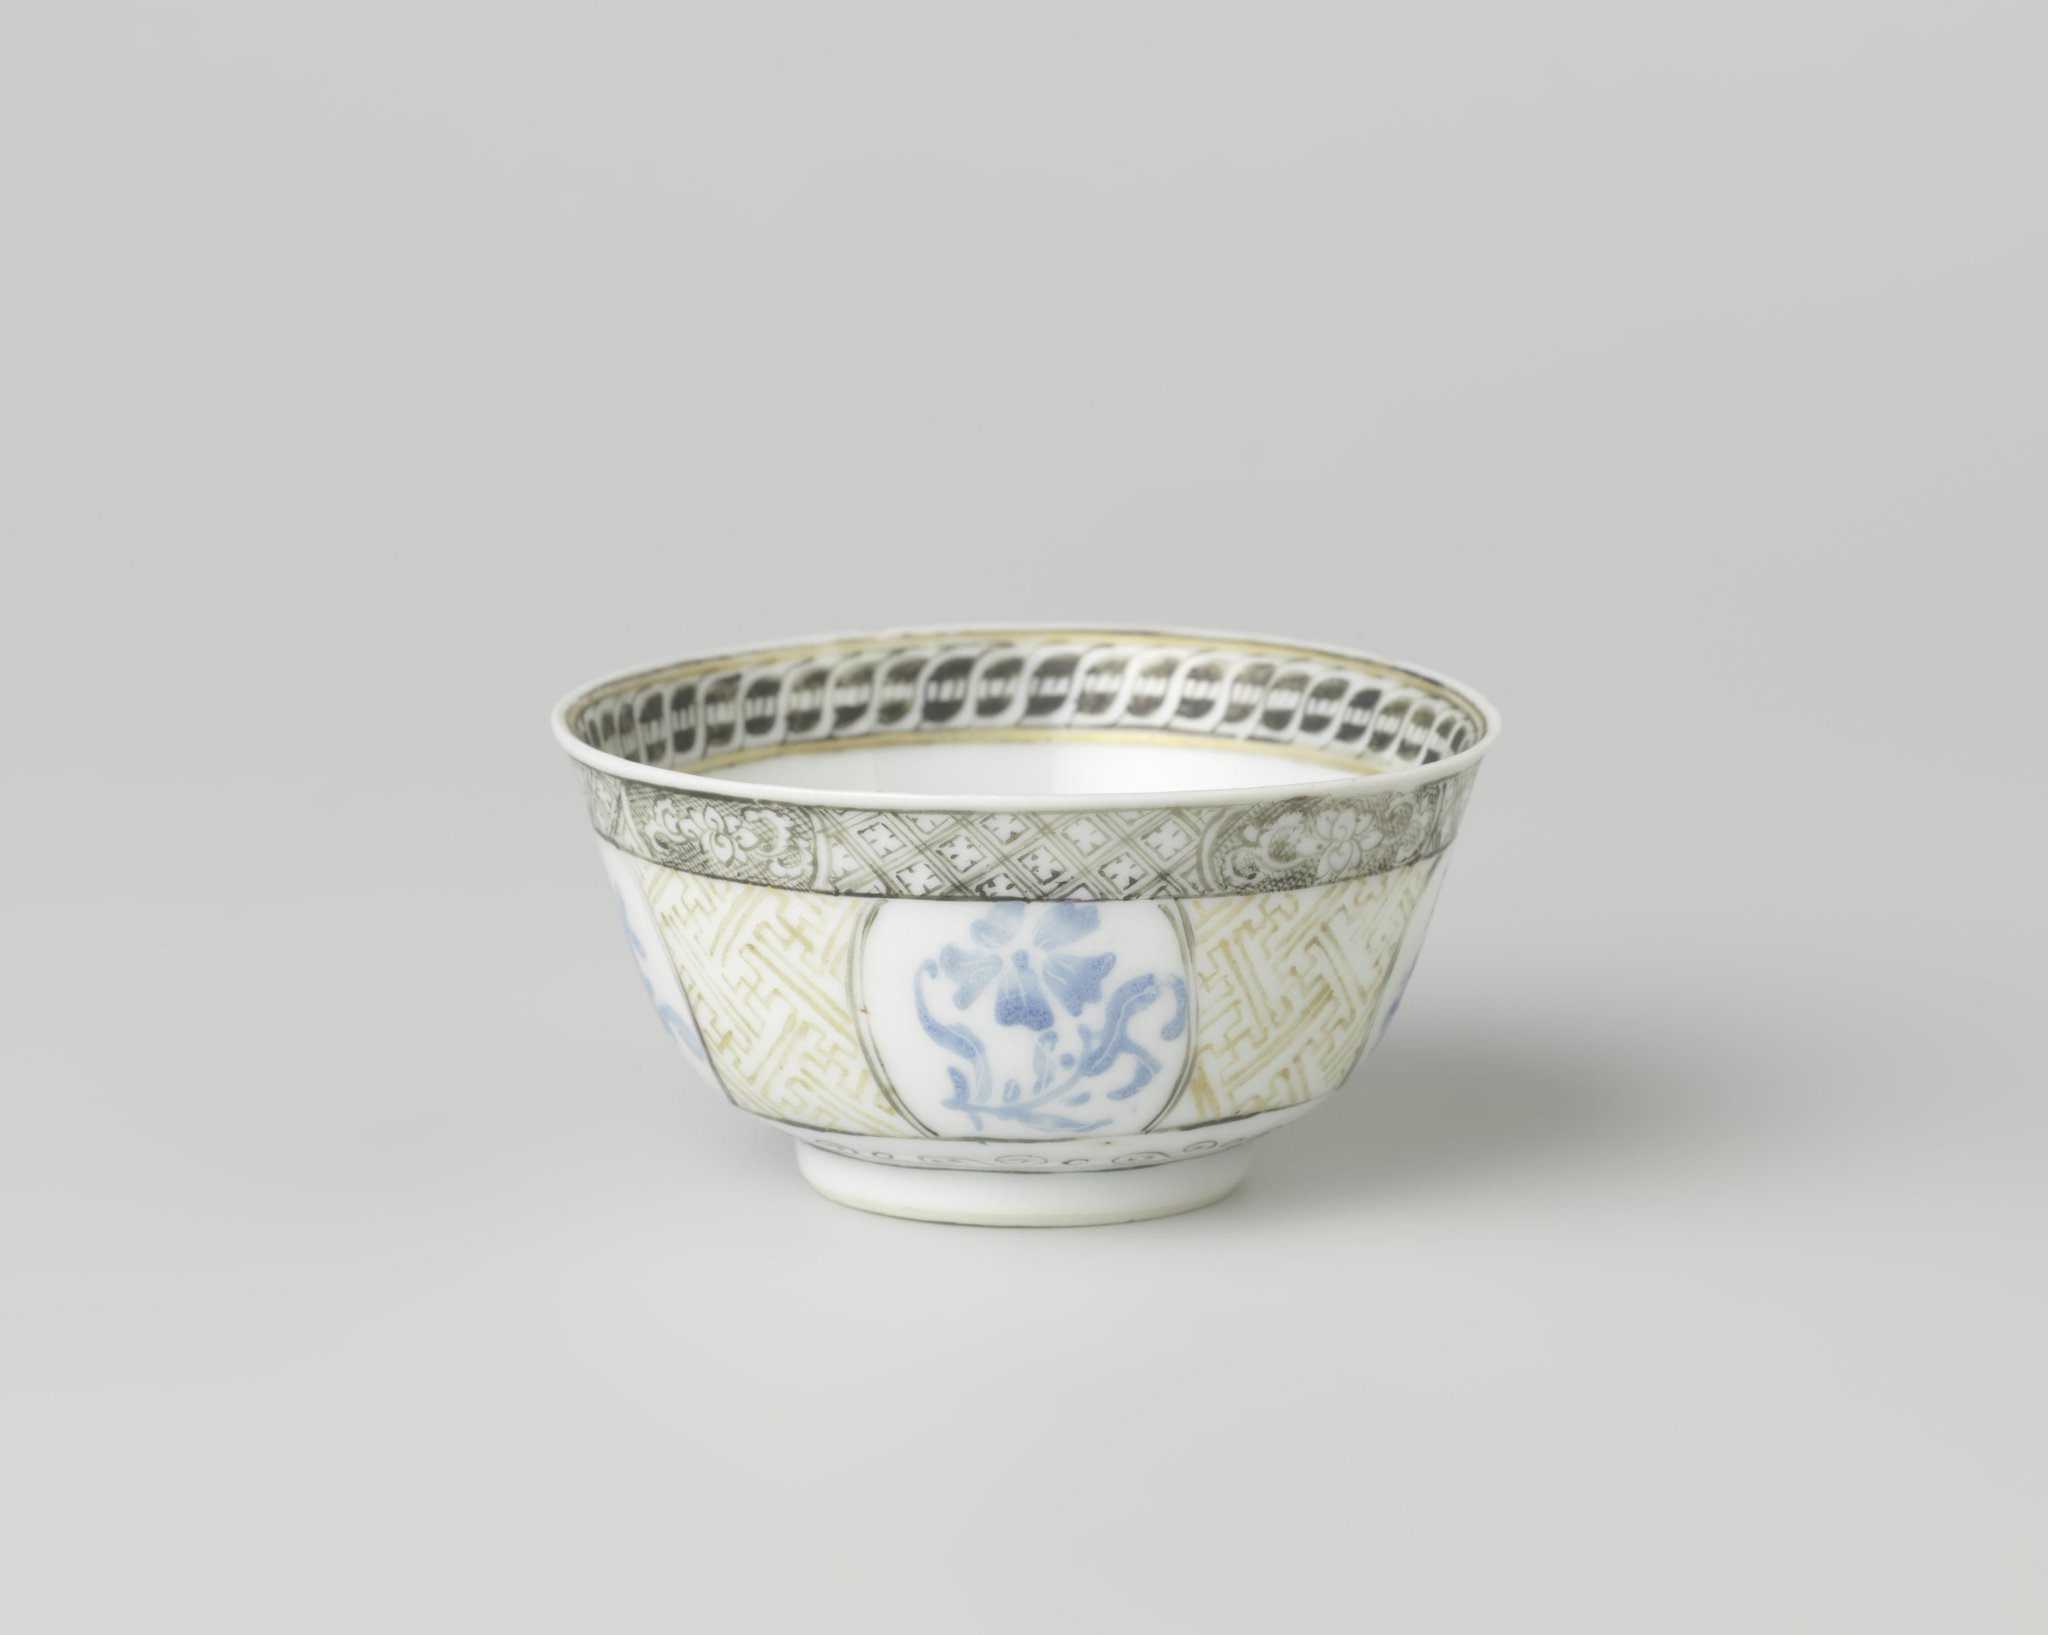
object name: kop en schotel, kop en schotel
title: Bell-shaped cup with flower sprays and ornamental borders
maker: Anonymous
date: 1725-1749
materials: glaze, gold, paint, porcelain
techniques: firing, gilding, turning, vitrification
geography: china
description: Kop en schotel met bloemen in encre de chine en een rand met bloemen in zwart en goud .